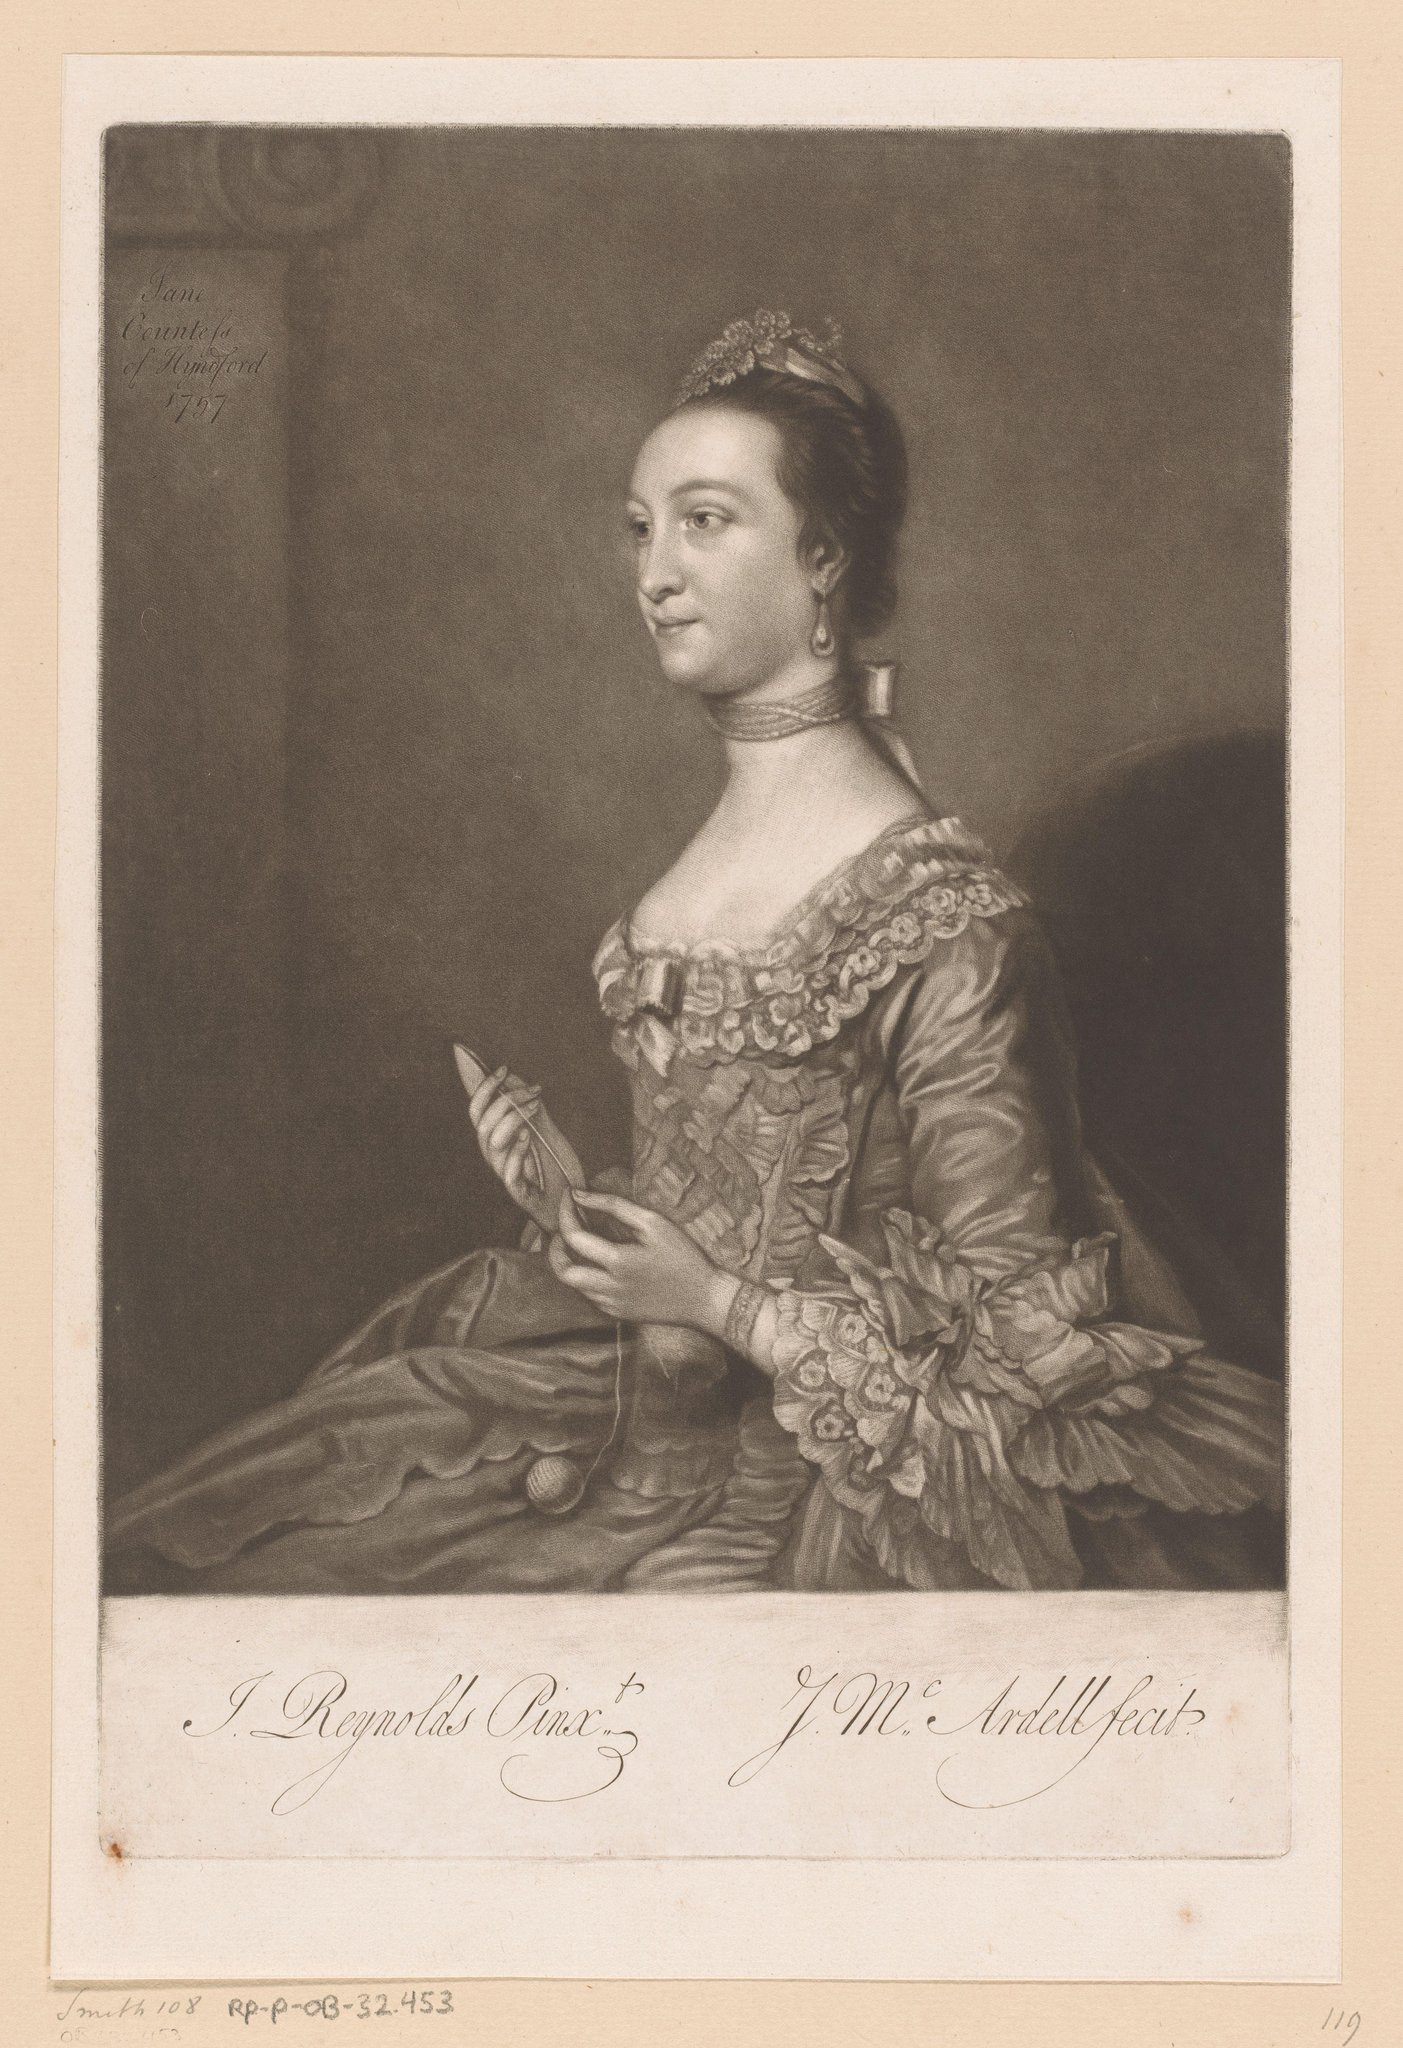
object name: print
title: Portret van Jane Carmichael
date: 1759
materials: paper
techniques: mezzotint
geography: london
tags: historical persons - bb - woman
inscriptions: collector's mark: Lugt 240